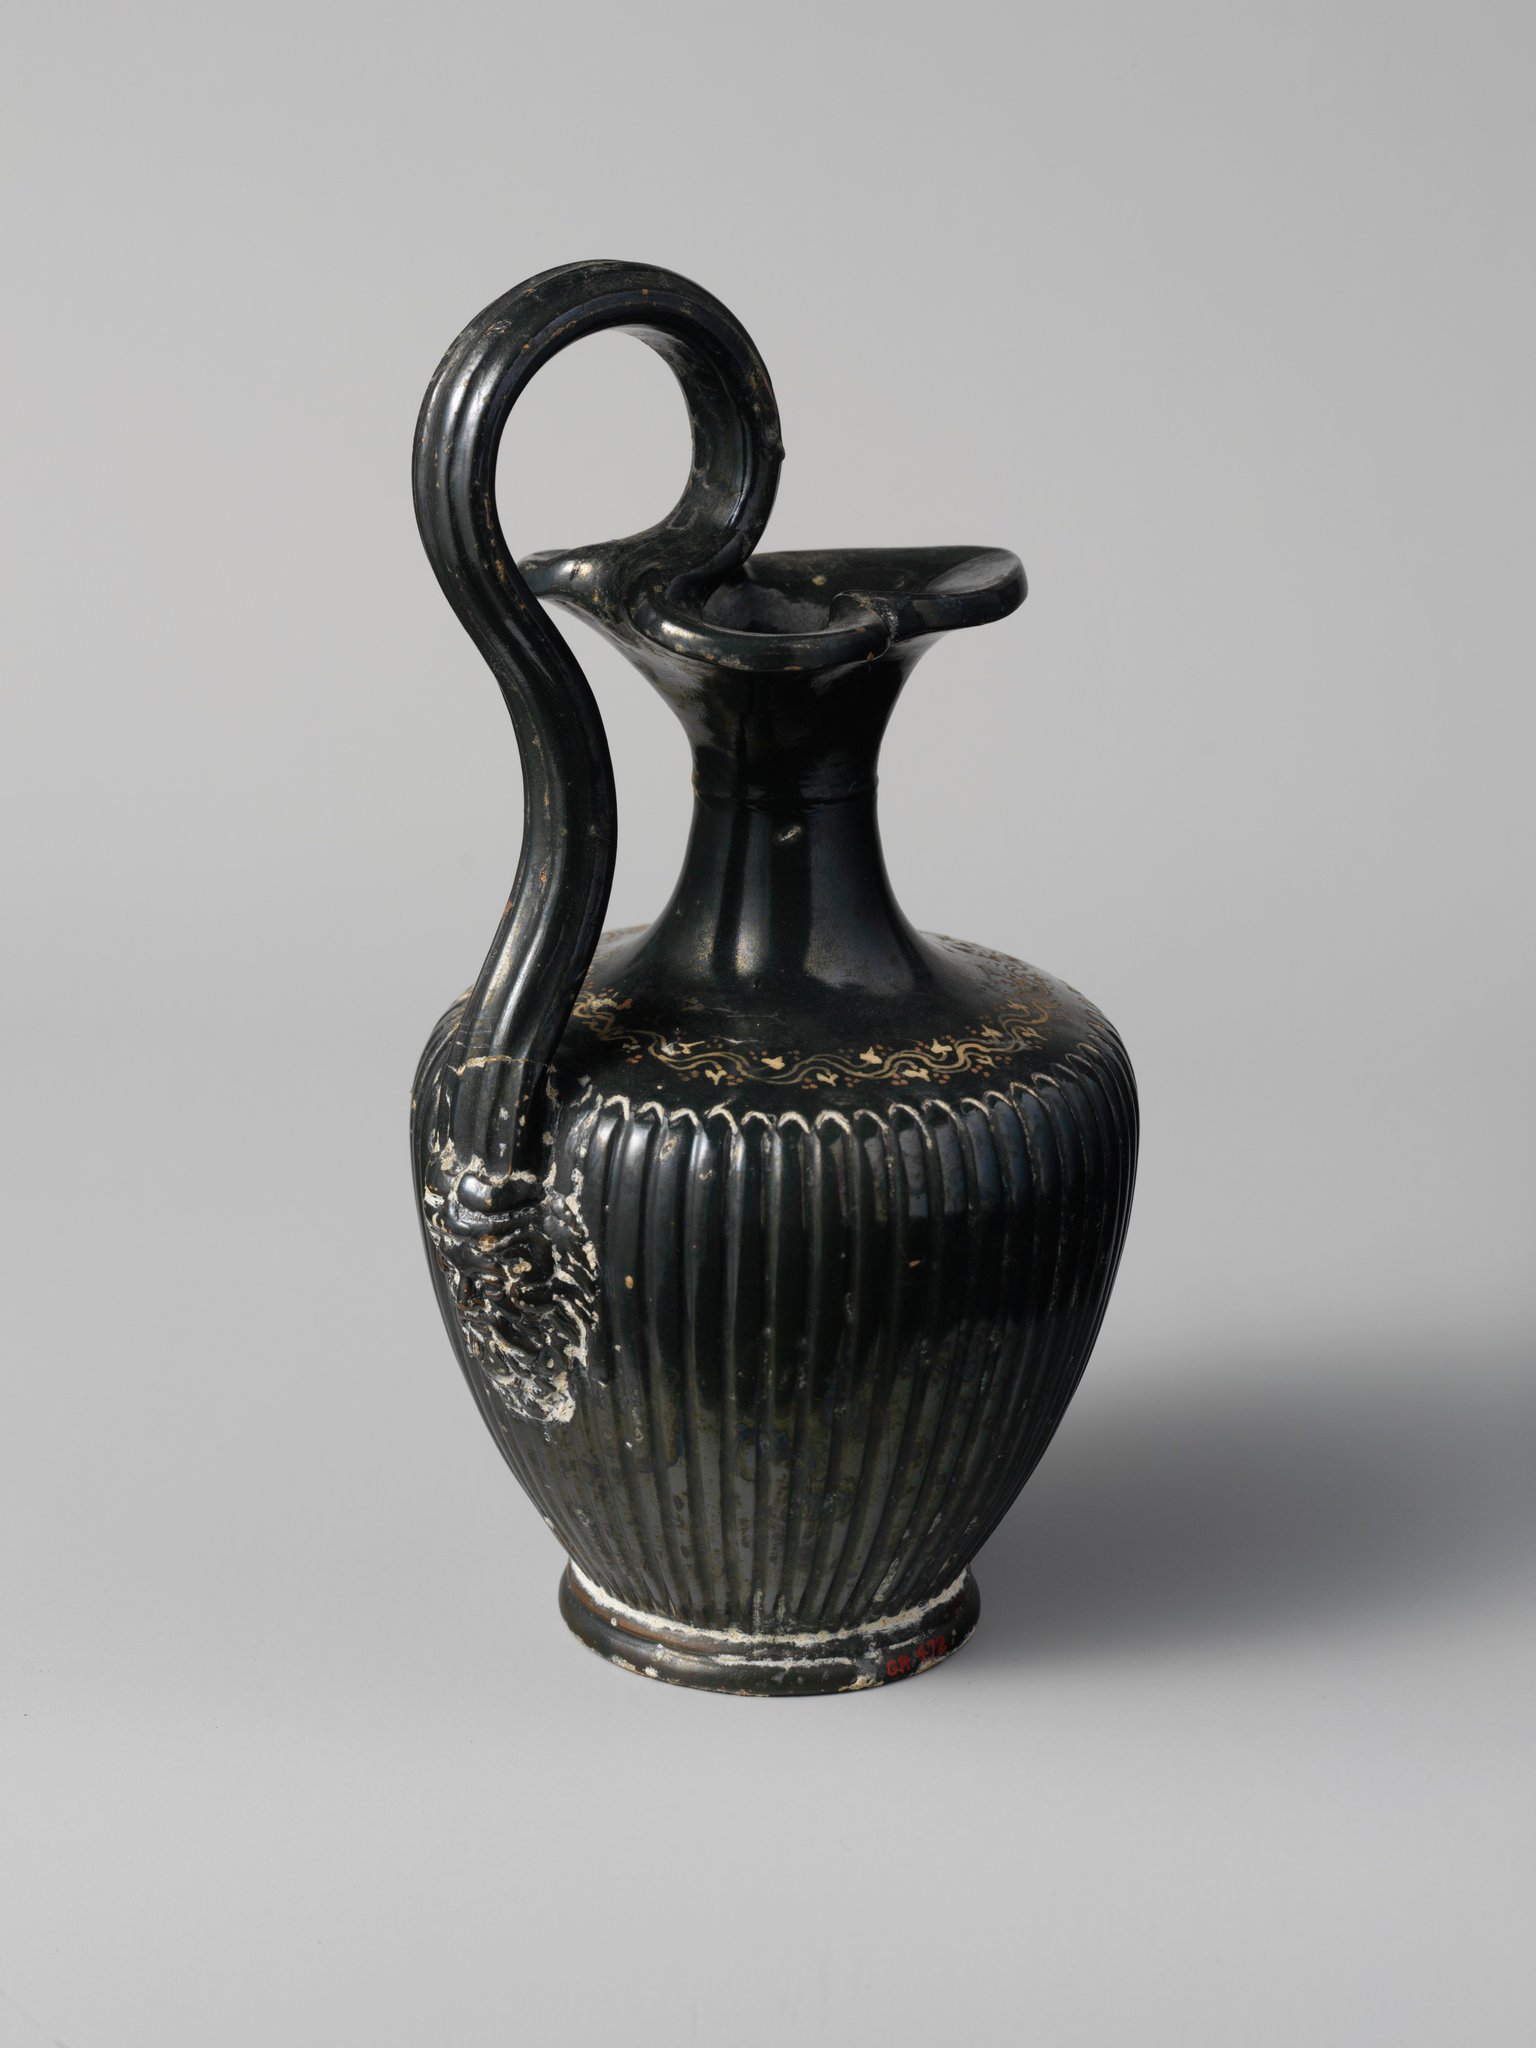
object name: oinochoe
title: Terracotta oinochoe (jug)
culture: etruscan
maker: group of vienna o.565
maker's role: artist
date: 300 BCE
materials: terracotta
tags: heads,satyrs